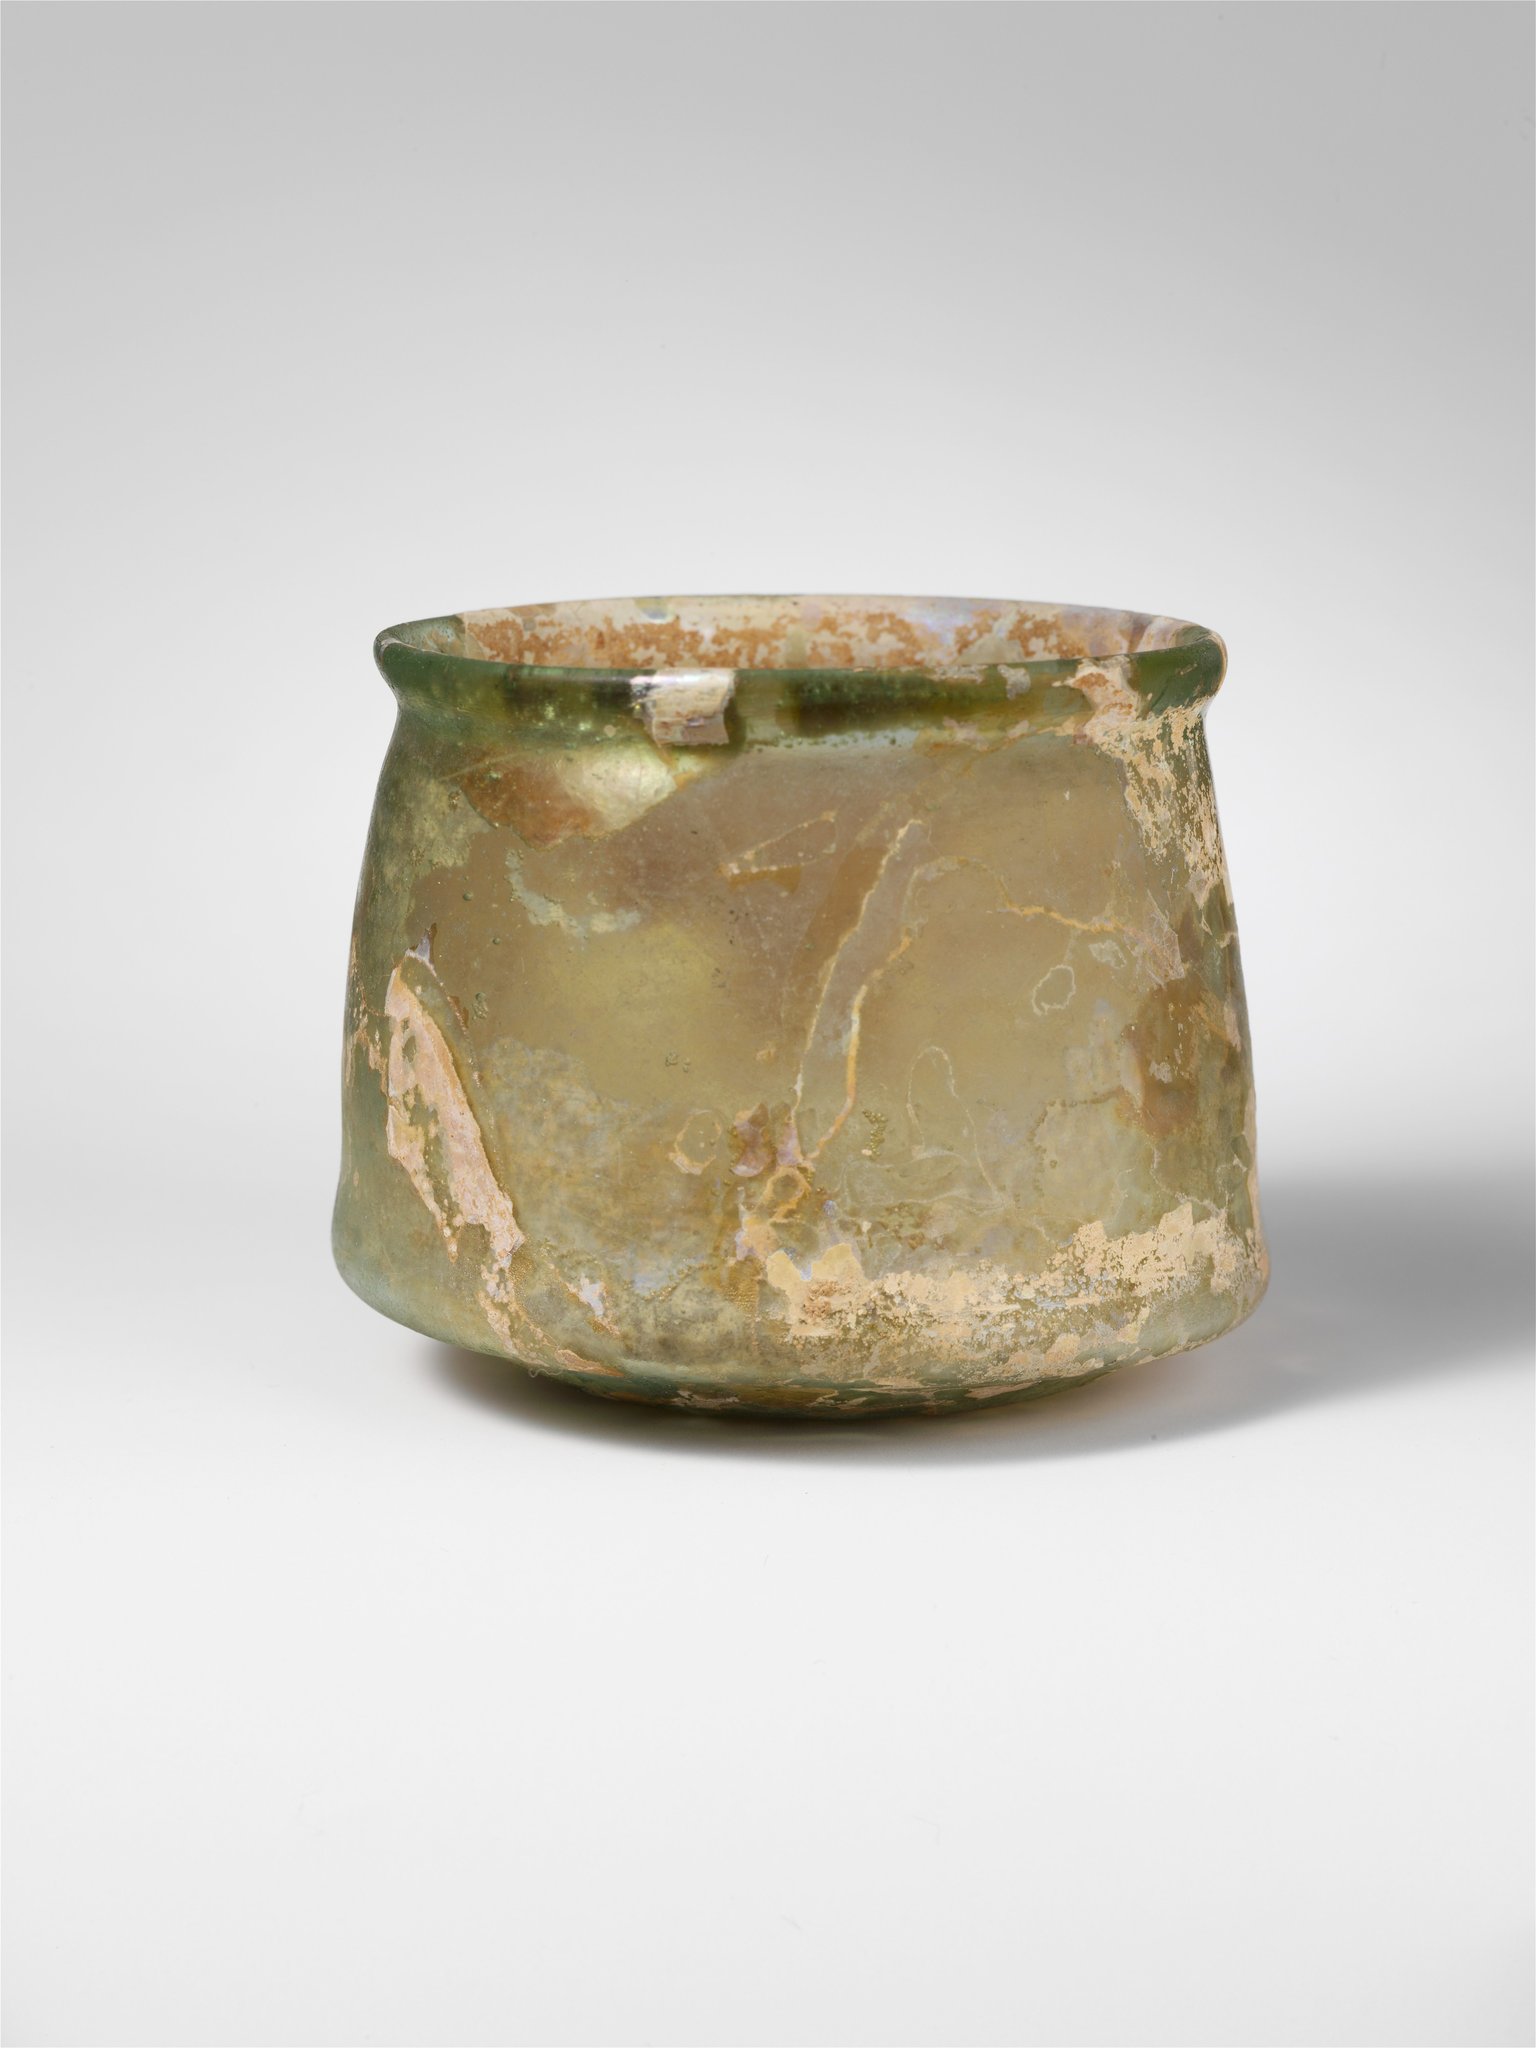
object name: cup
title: Glass cup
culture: roman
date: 101-300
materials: glass